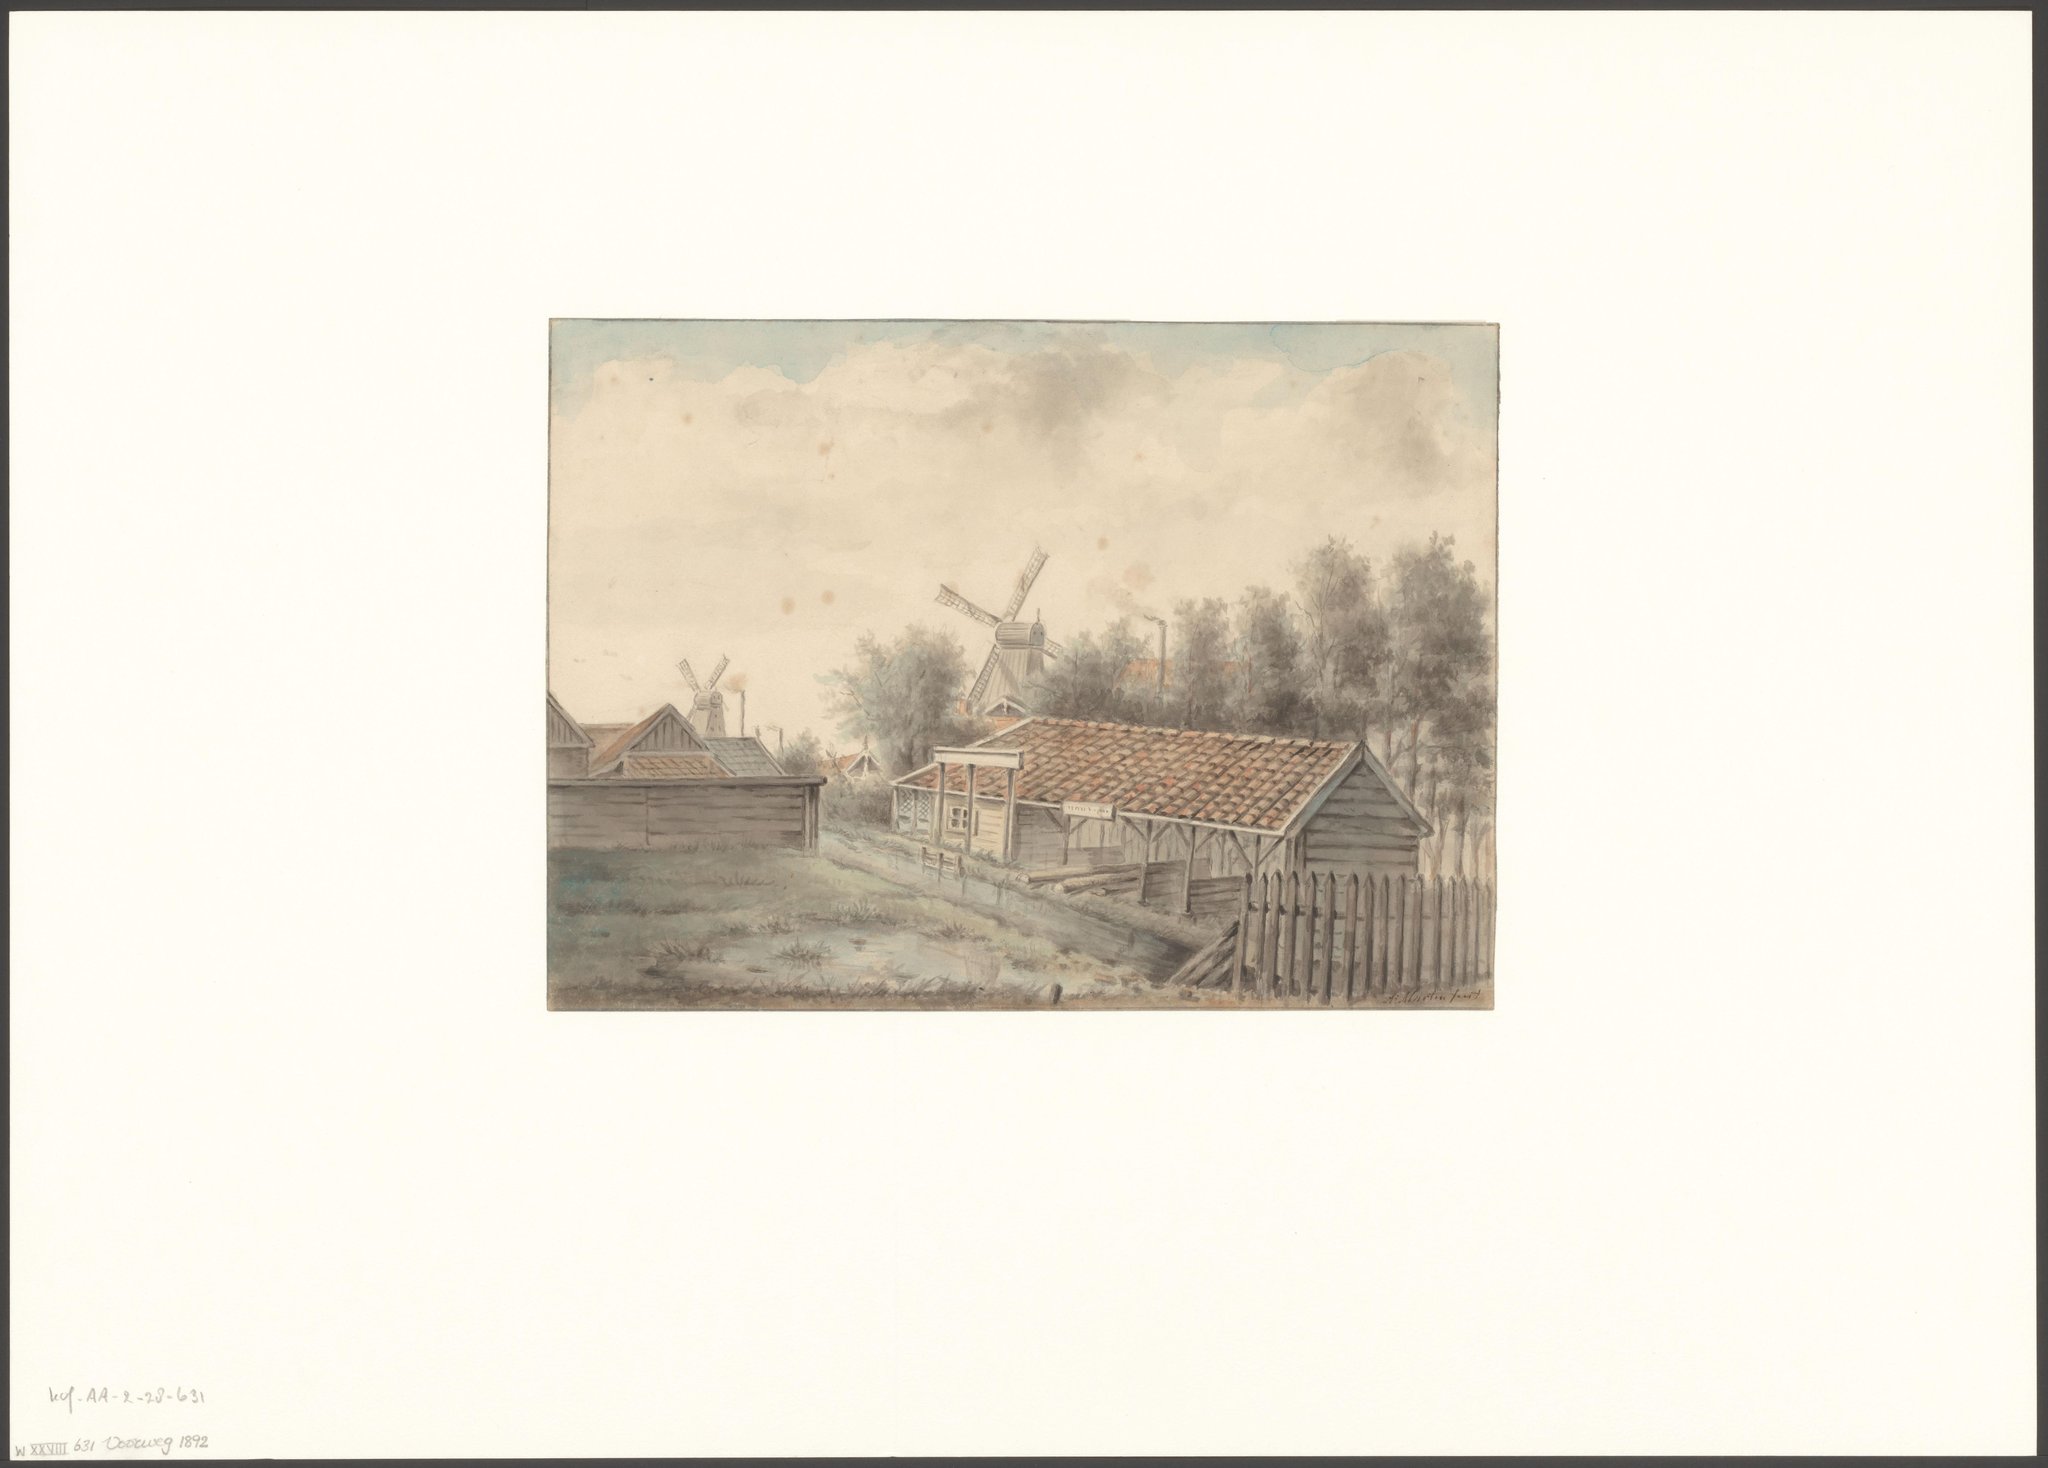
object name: drawing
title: Gezicht op molen De Kat vanaf de Voorweg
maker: albert martin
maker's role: draughtsman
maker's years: 1827-1900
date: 1811-1892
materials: ink, paper, pencil, watercolor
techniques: brush, pen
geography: amsterdam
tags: city-view in general; 'veduta', windmill in landscape, shed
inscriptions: signature: ‘A:Martin fecit’, collector's mark: Lugt 800a, inscription: ‘Gezicht op den (...) Voorweg November 1892’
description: Tekening binnen de Atlas Van Eck ingedeeld op wijknummer 28.